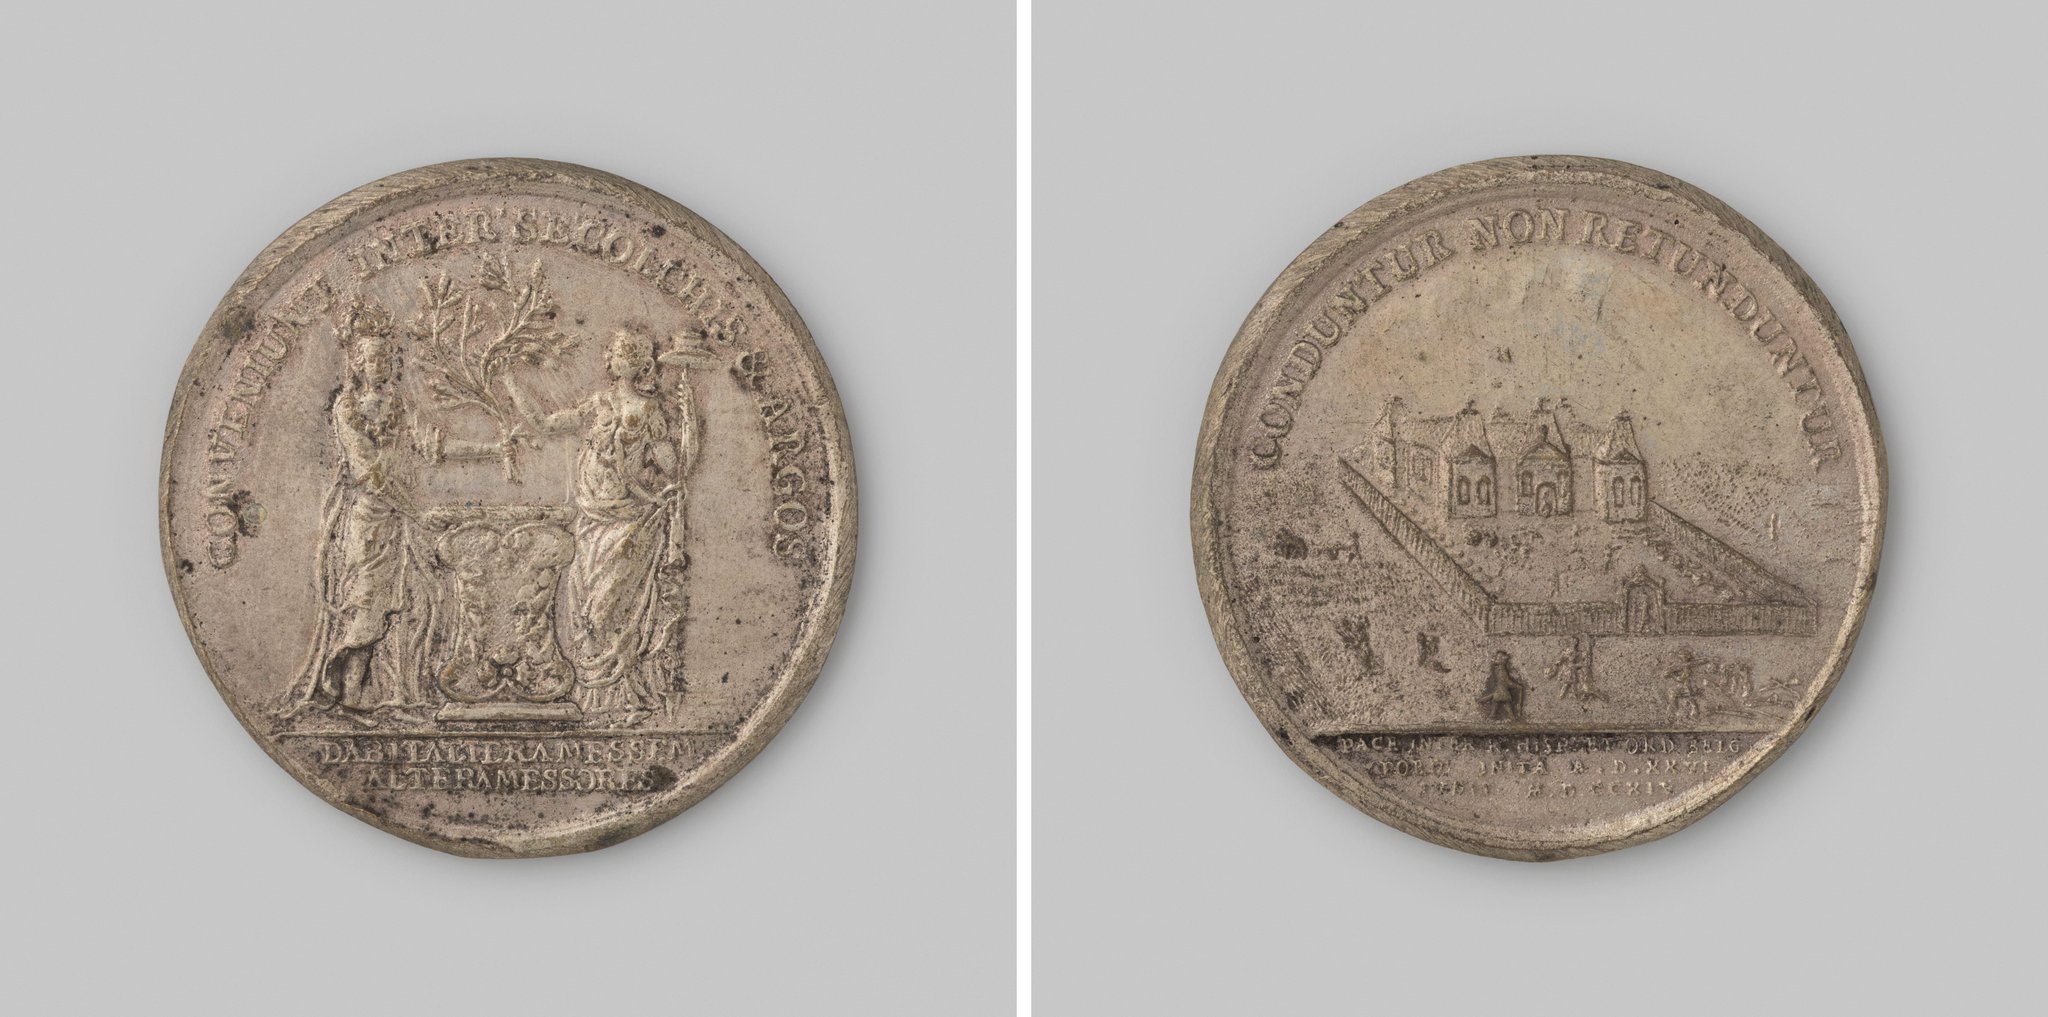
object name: history medal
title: Vrede van Utrecht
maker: Anonymous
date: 1714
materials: silver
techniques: striking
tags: utrecht